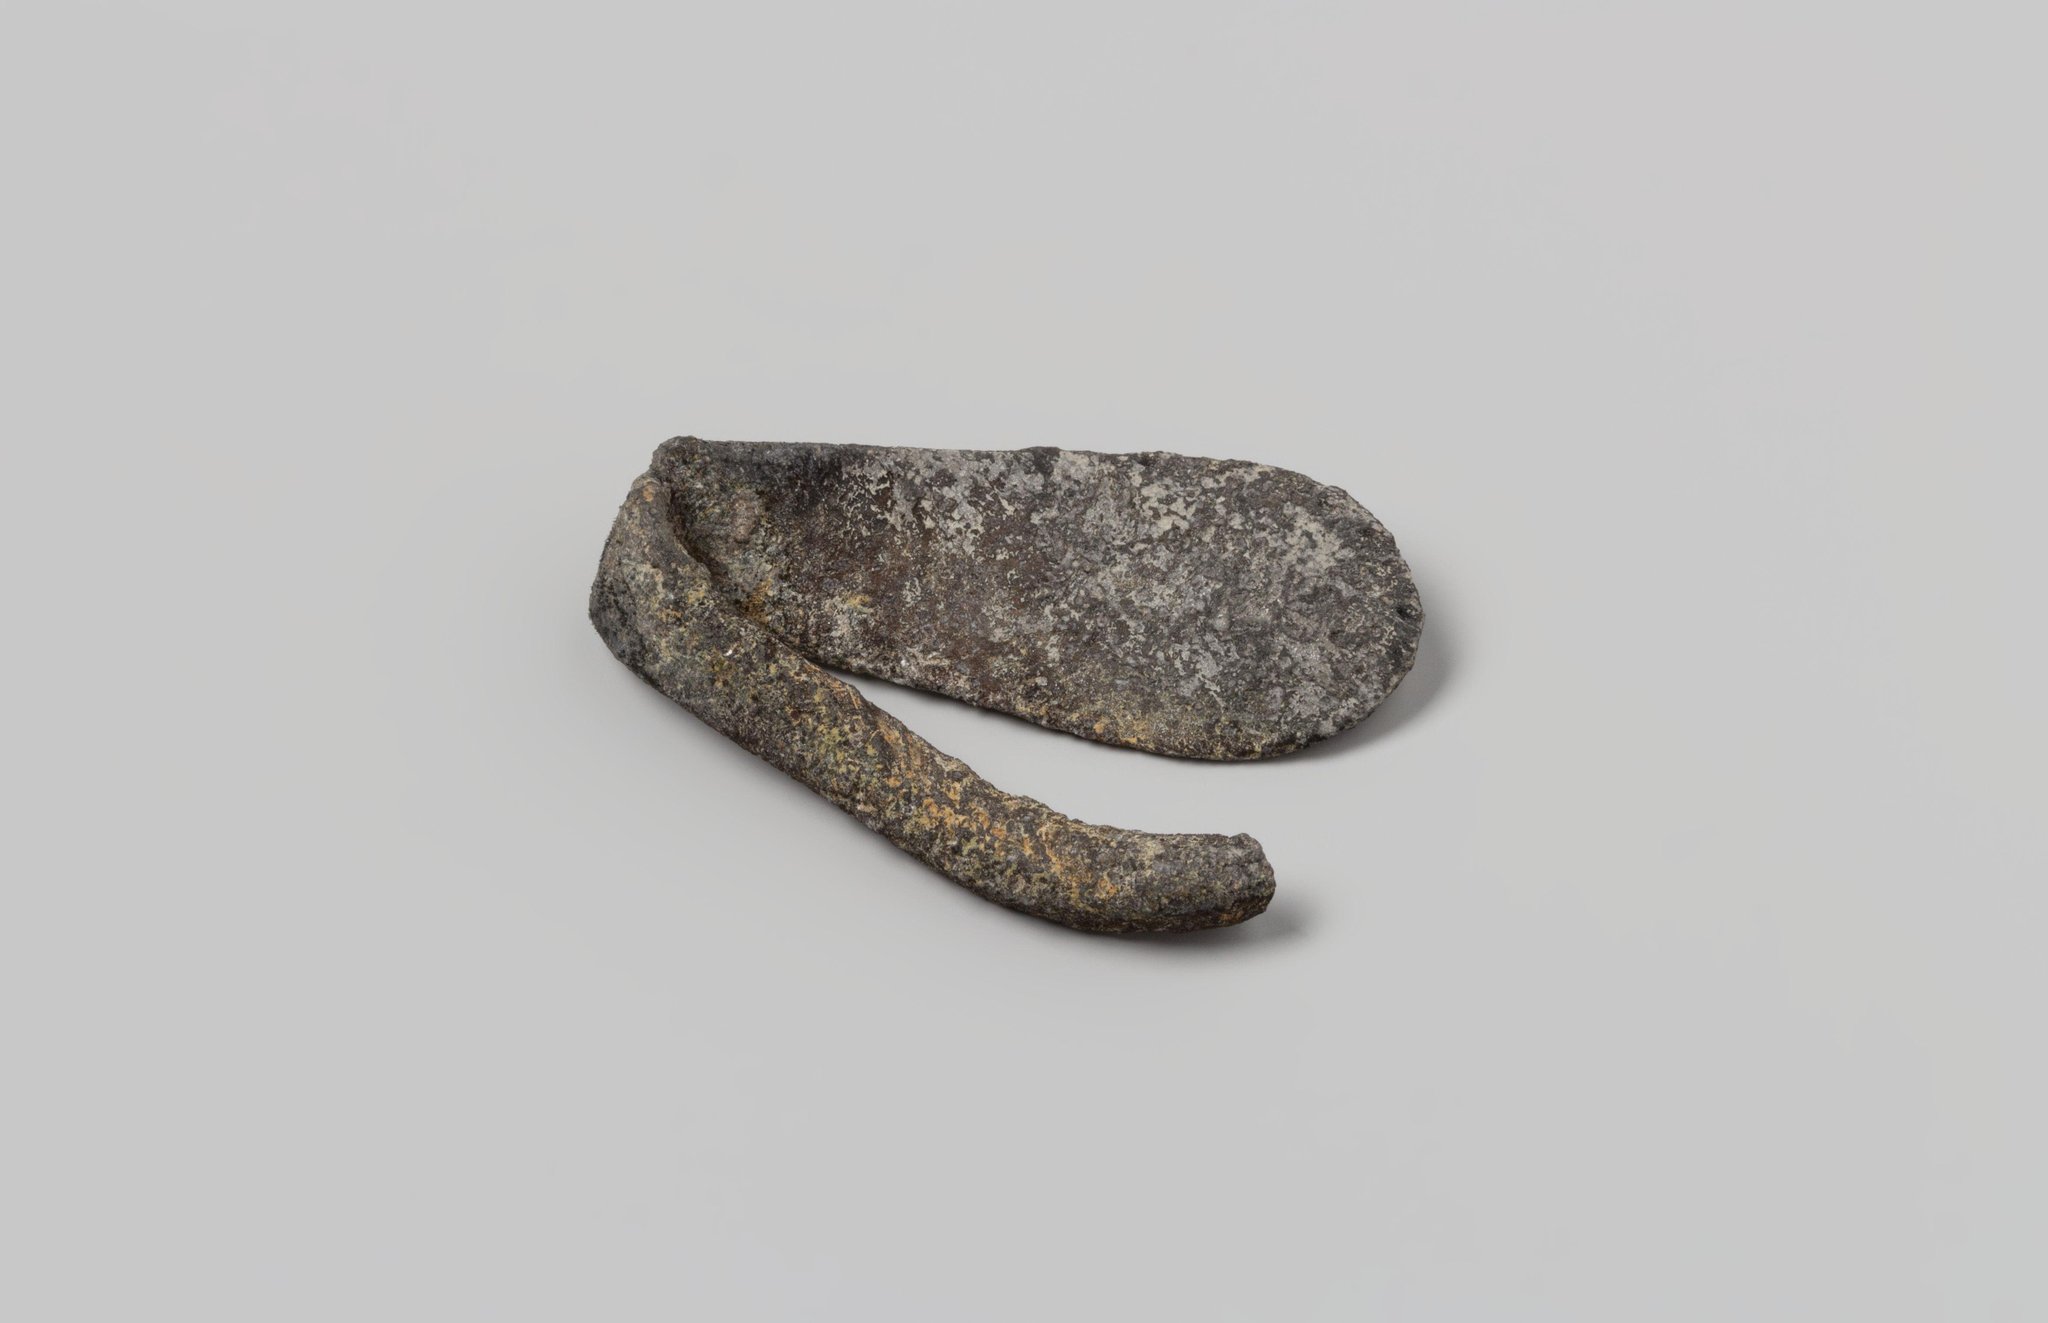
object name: fork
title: Steel van vork of lepel uit het wrak van de Oost-Indiëvaarder Hollandia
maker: Anonymous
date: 1700-1743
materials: tin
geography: netherlands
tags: verenigde oostindische compagnie, hollandia (schip), annet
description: Cutlery, fragment: stem of fork or spoon; fragm, end, sim. NG 1980-27H527, no inscription legible.